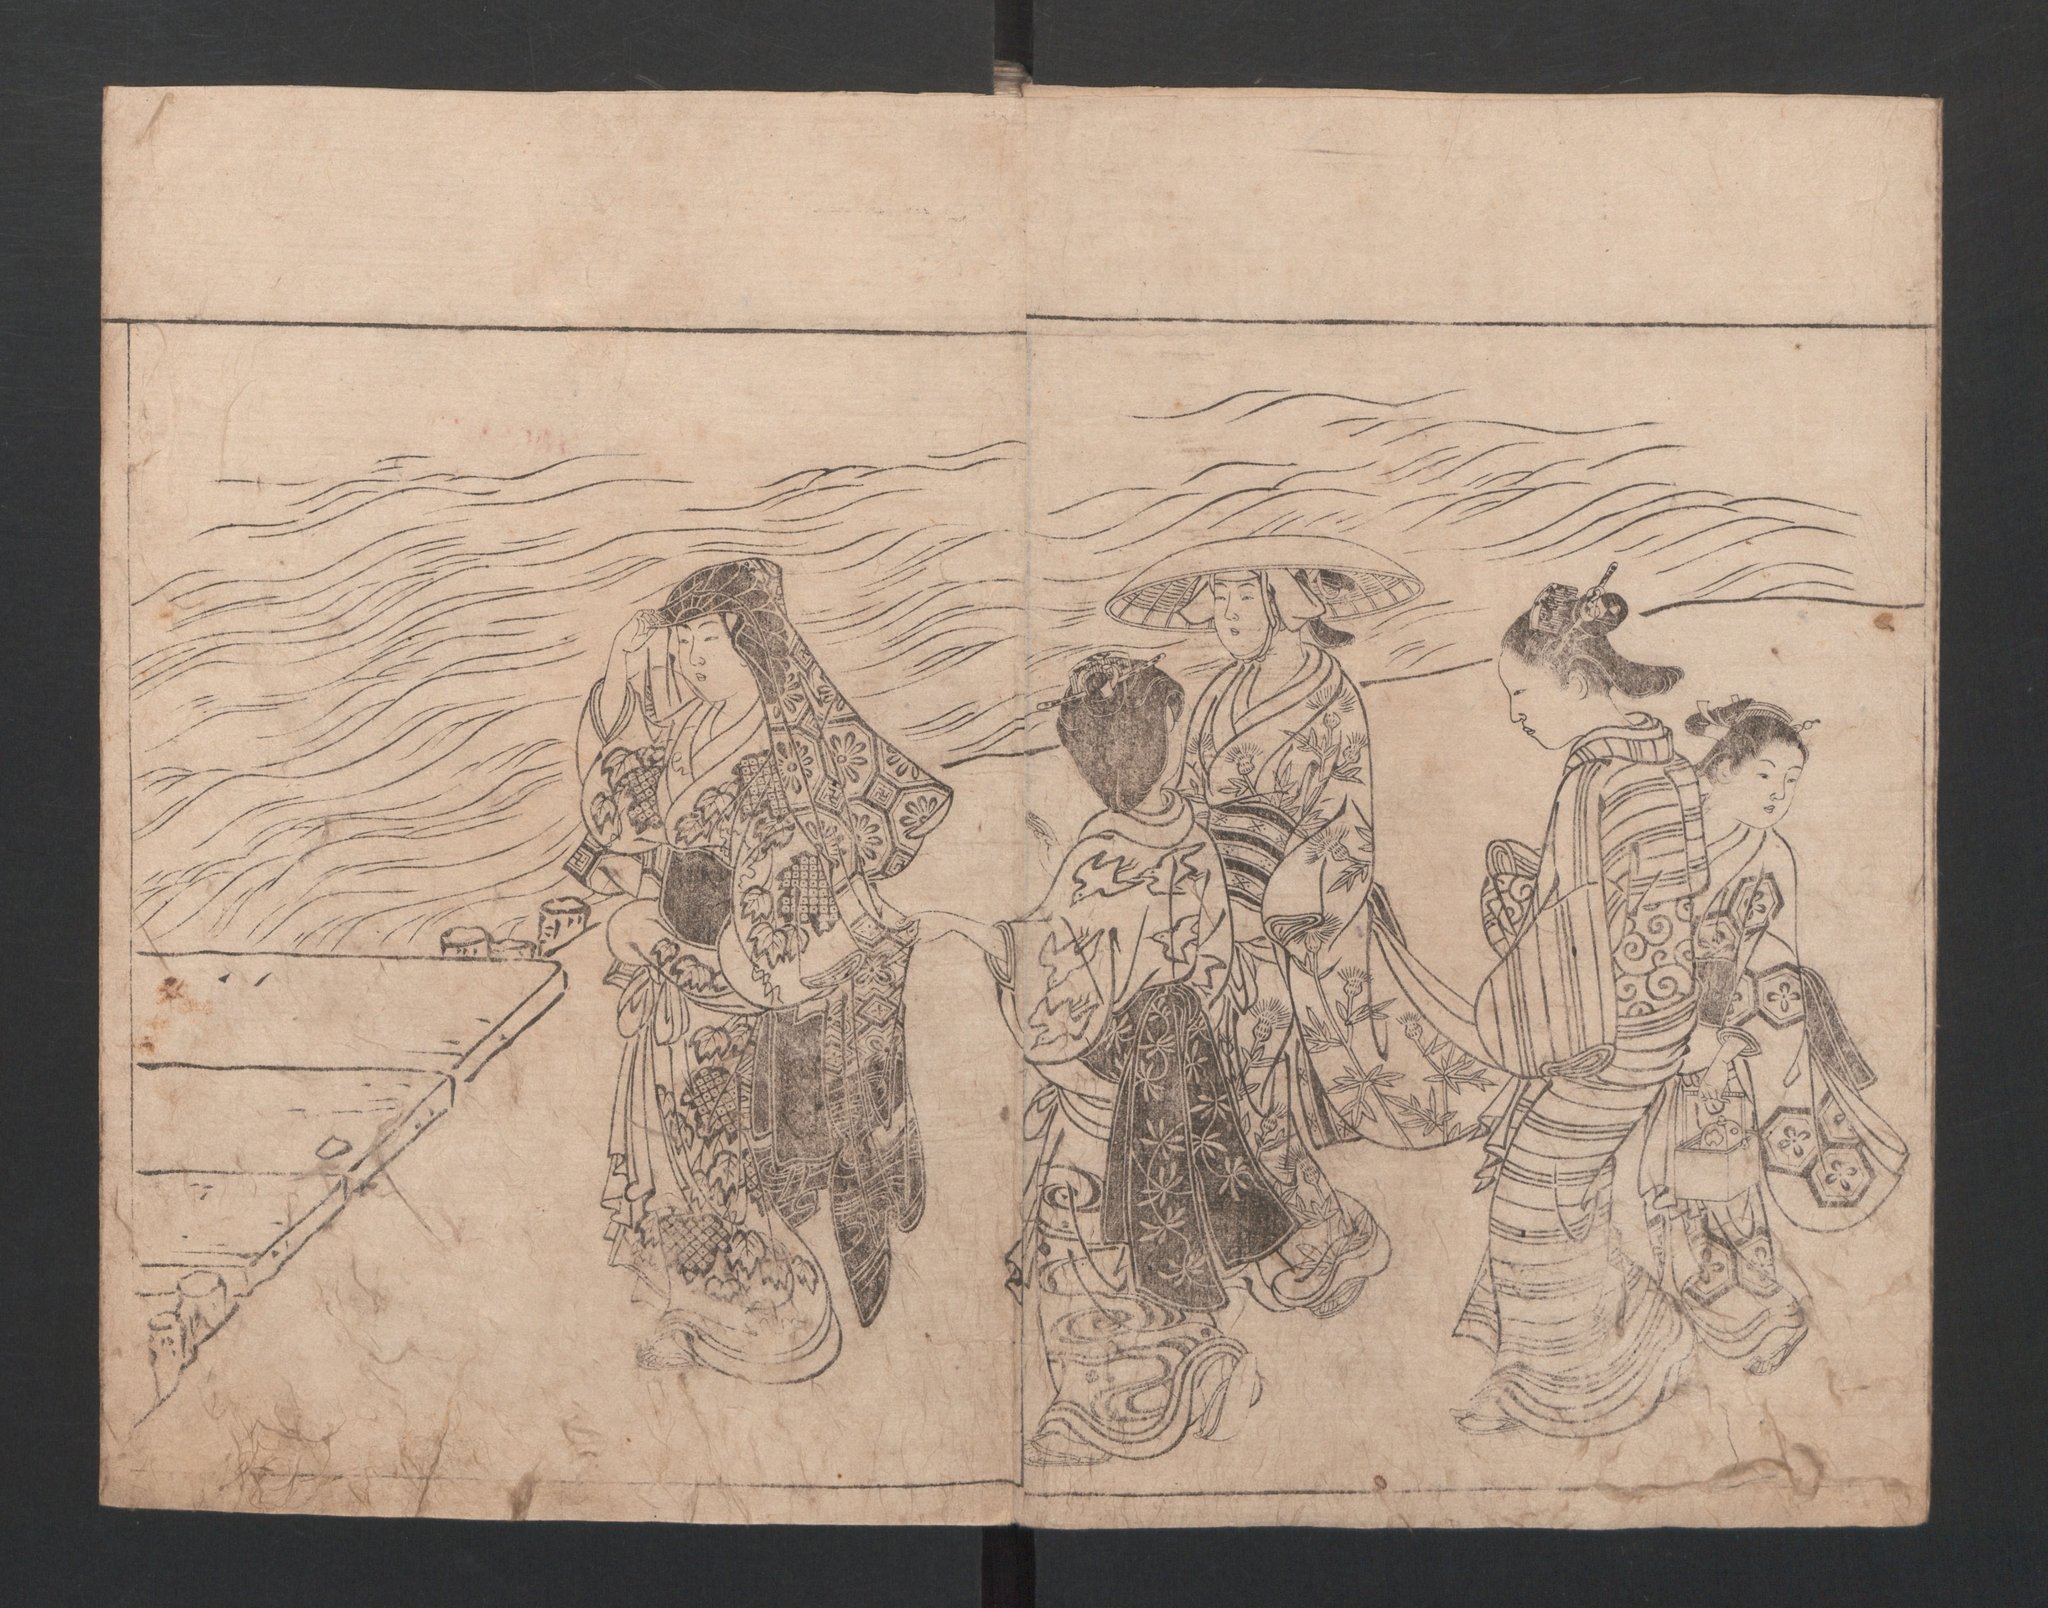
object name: illustrated book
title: The Mrawing manual: The Evergreens (Ehon Tokiwagusa) 絵本常盤草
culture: japanese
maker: nishikawa sukenobu 西川祐信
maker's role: artist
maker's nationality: japanese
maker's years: 1671-1750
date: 1731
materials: ink, paper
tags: women